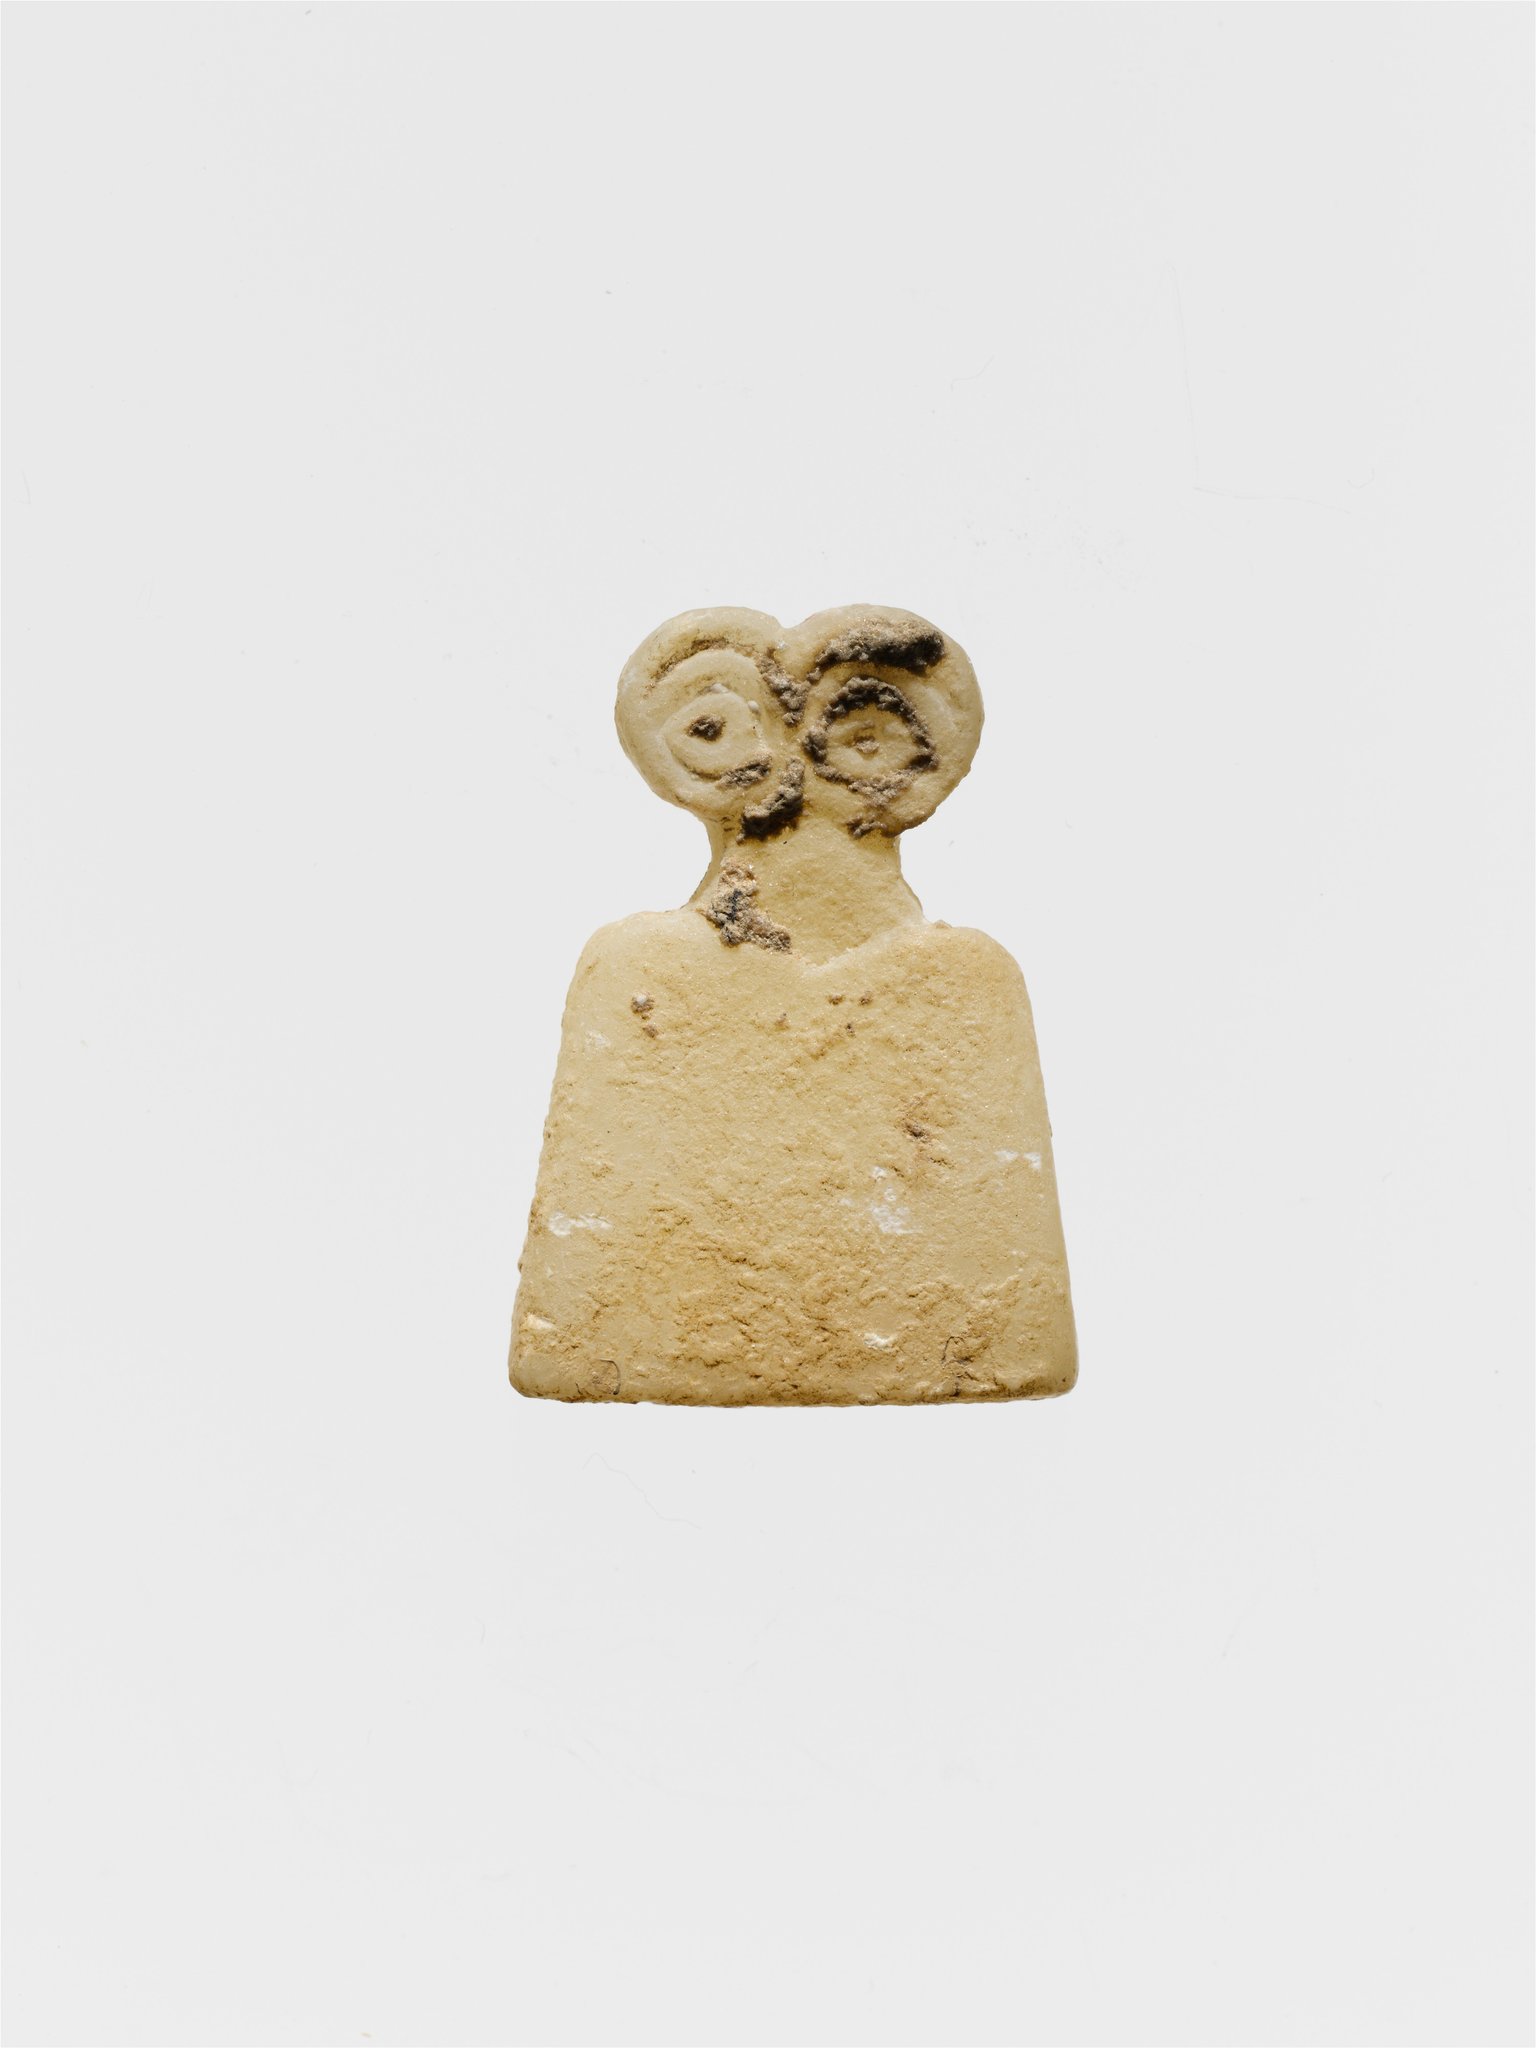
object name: sculpture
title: Eye idol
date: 3700-3500 BCE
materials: alabaster, gypsum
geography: syria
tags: eyes